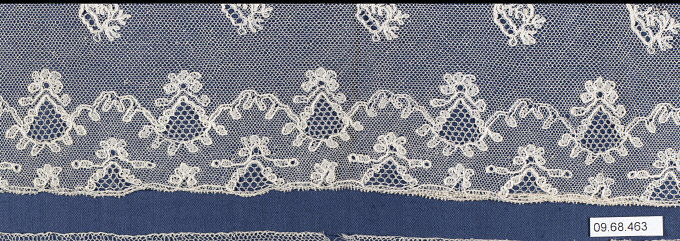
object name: fragment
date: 1801-1900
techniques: lace